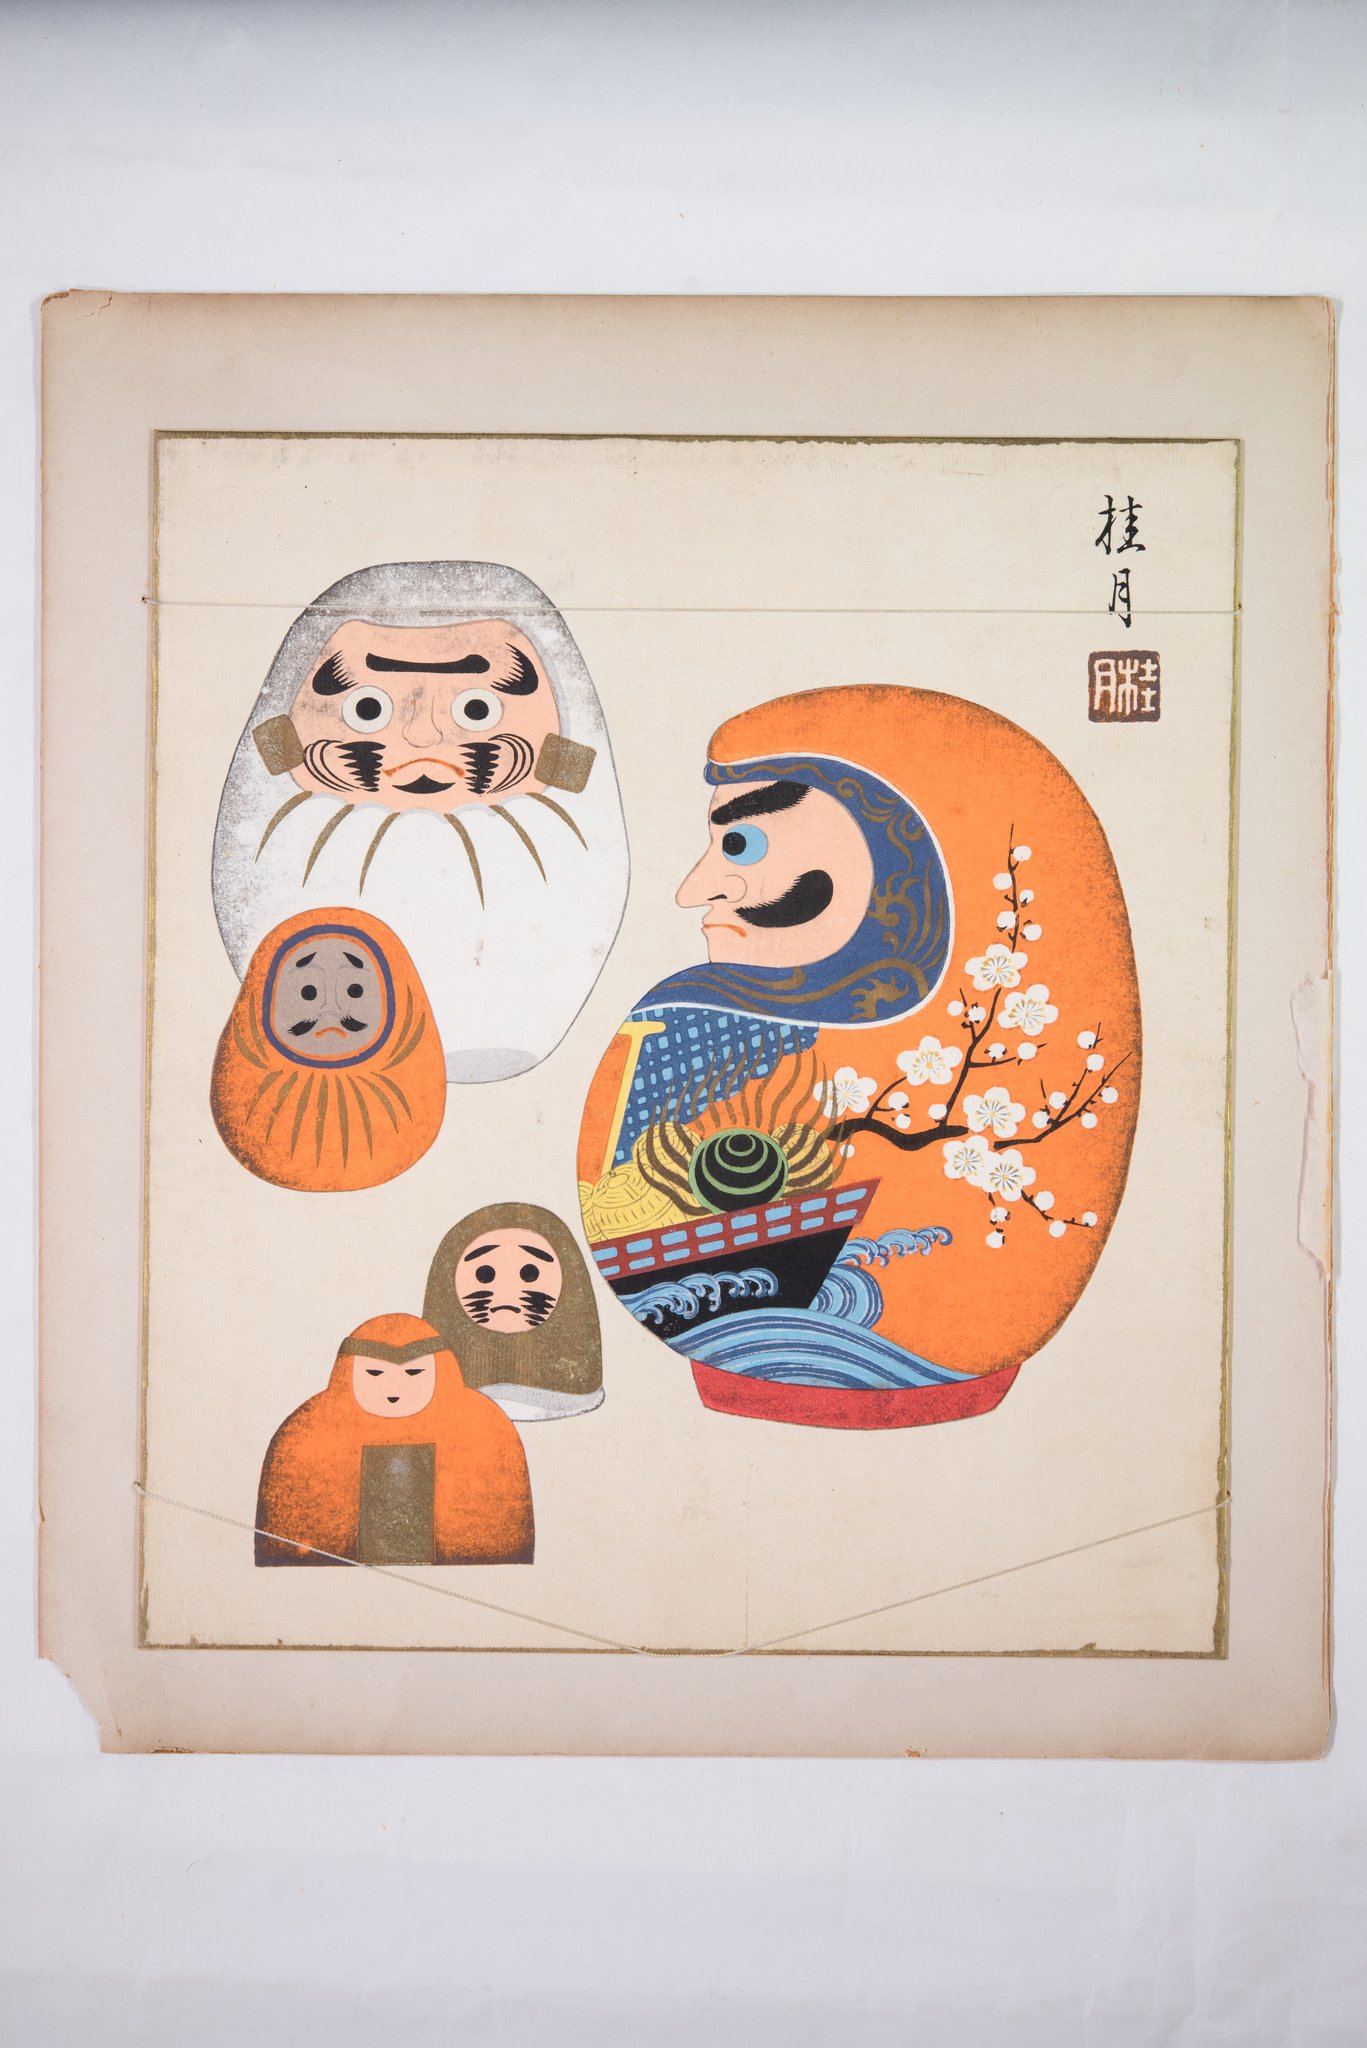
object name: illustrated book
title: Japanese Folk Toys: Spring (Kyōdo gangu shū: haru) 郷土玩具集: 春（きょうどがんぐしゅう: はる）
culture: japanese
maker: yamashita hakuba 山下白馬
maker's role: artist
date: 1935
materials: ink, paper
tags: toys